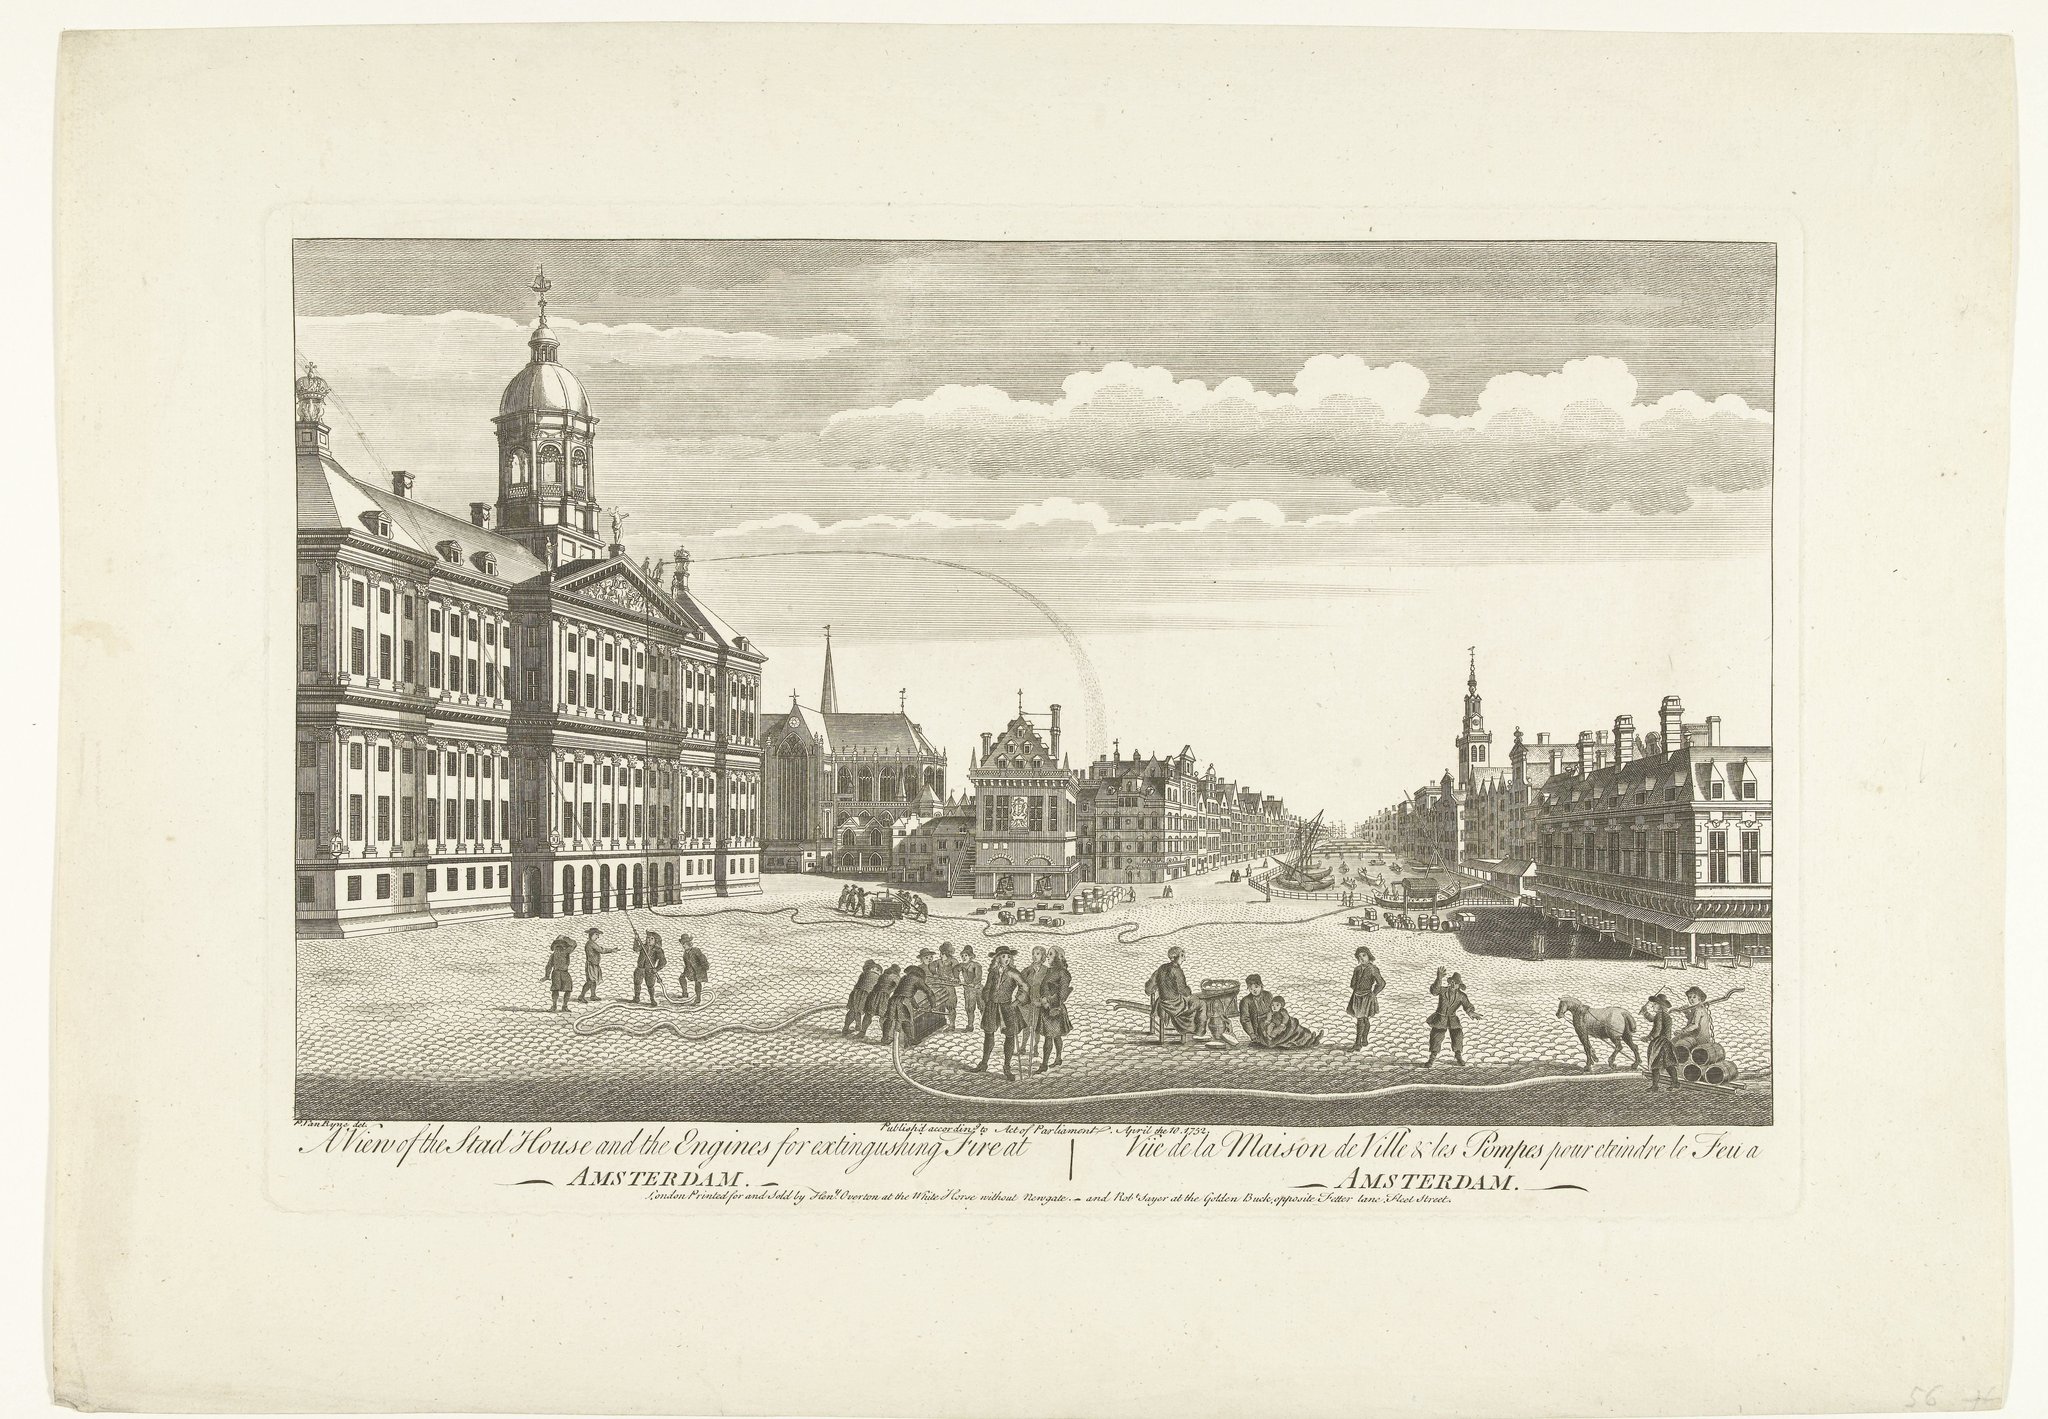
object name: print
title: Demonstratie van de slangbrandspuiten bij het Stadhuis op de Dam, ca. 1750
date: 1752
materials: paper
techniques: etching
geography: england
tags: amsterdam, painter, print maker, draughtsman, jan van der heyden, fire-extinguishing equipment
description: Demonstratie van de slangbrandspuiten bij het Stadhuis op de Dam, ca. 1750. Vanaf de gevel wordt een straal water op de Dam gespoten. Behoort tot de bijprenten bij het Brandspuitenboek van Jan van der Heyden.